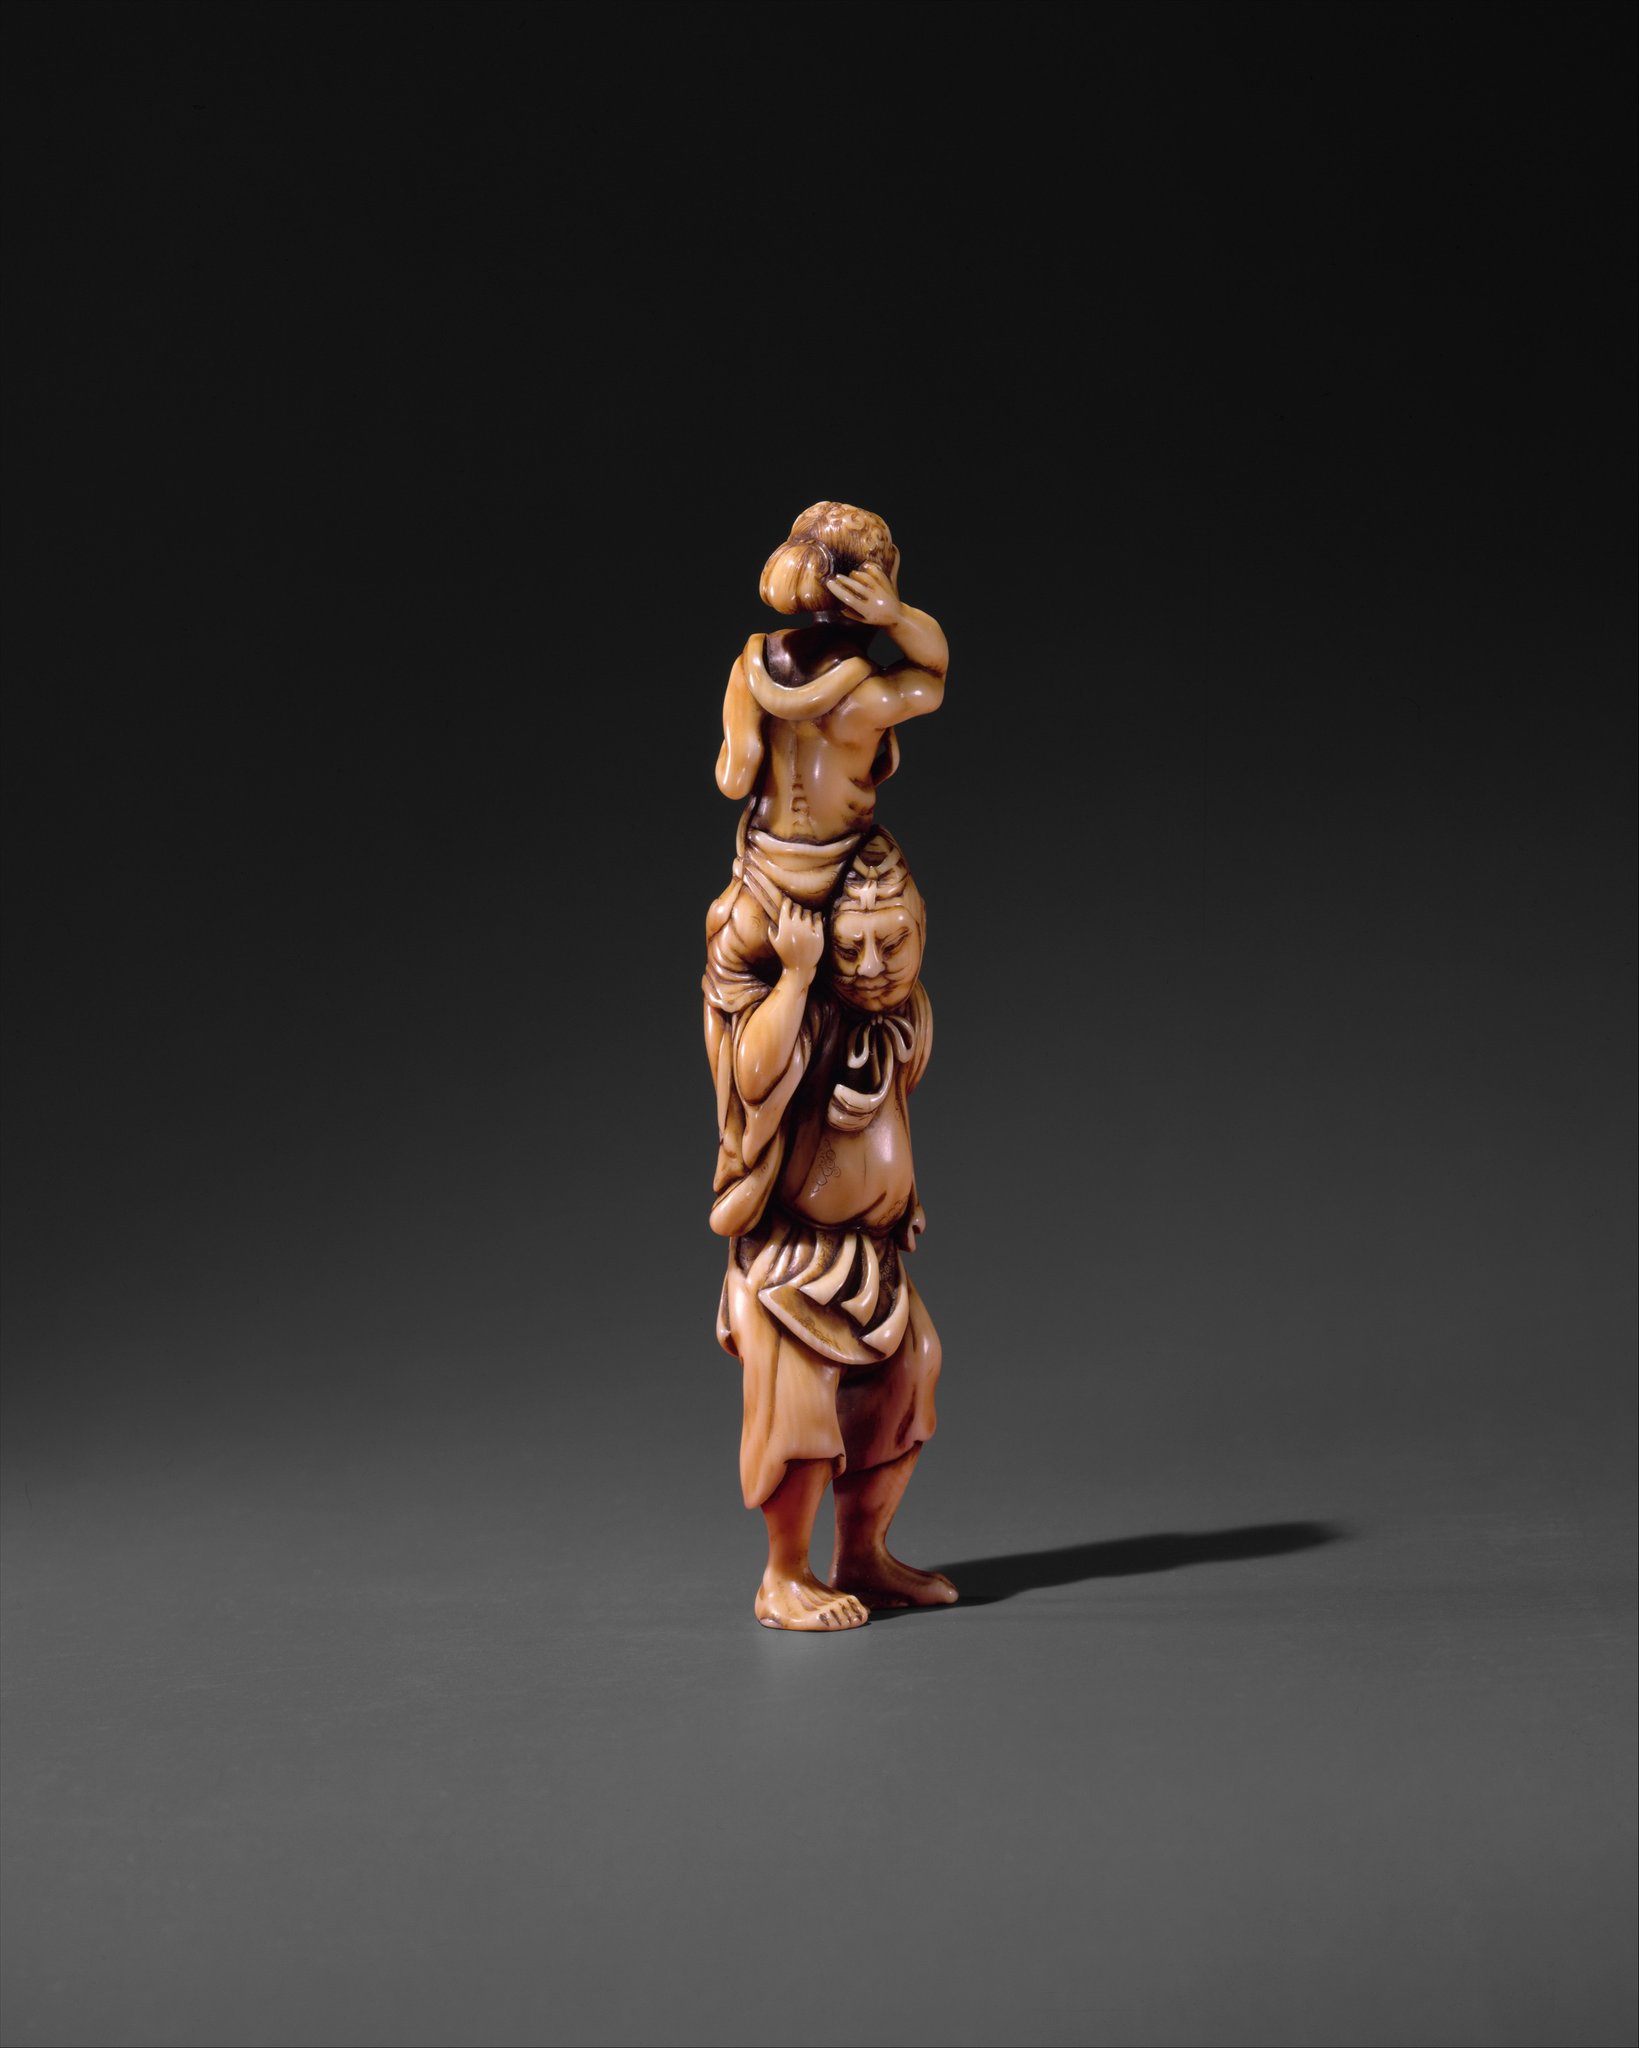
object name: netsuke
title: Netsuke of Omori Hikoshichi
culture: japanese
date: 1701-1800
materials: ivory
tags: human figures